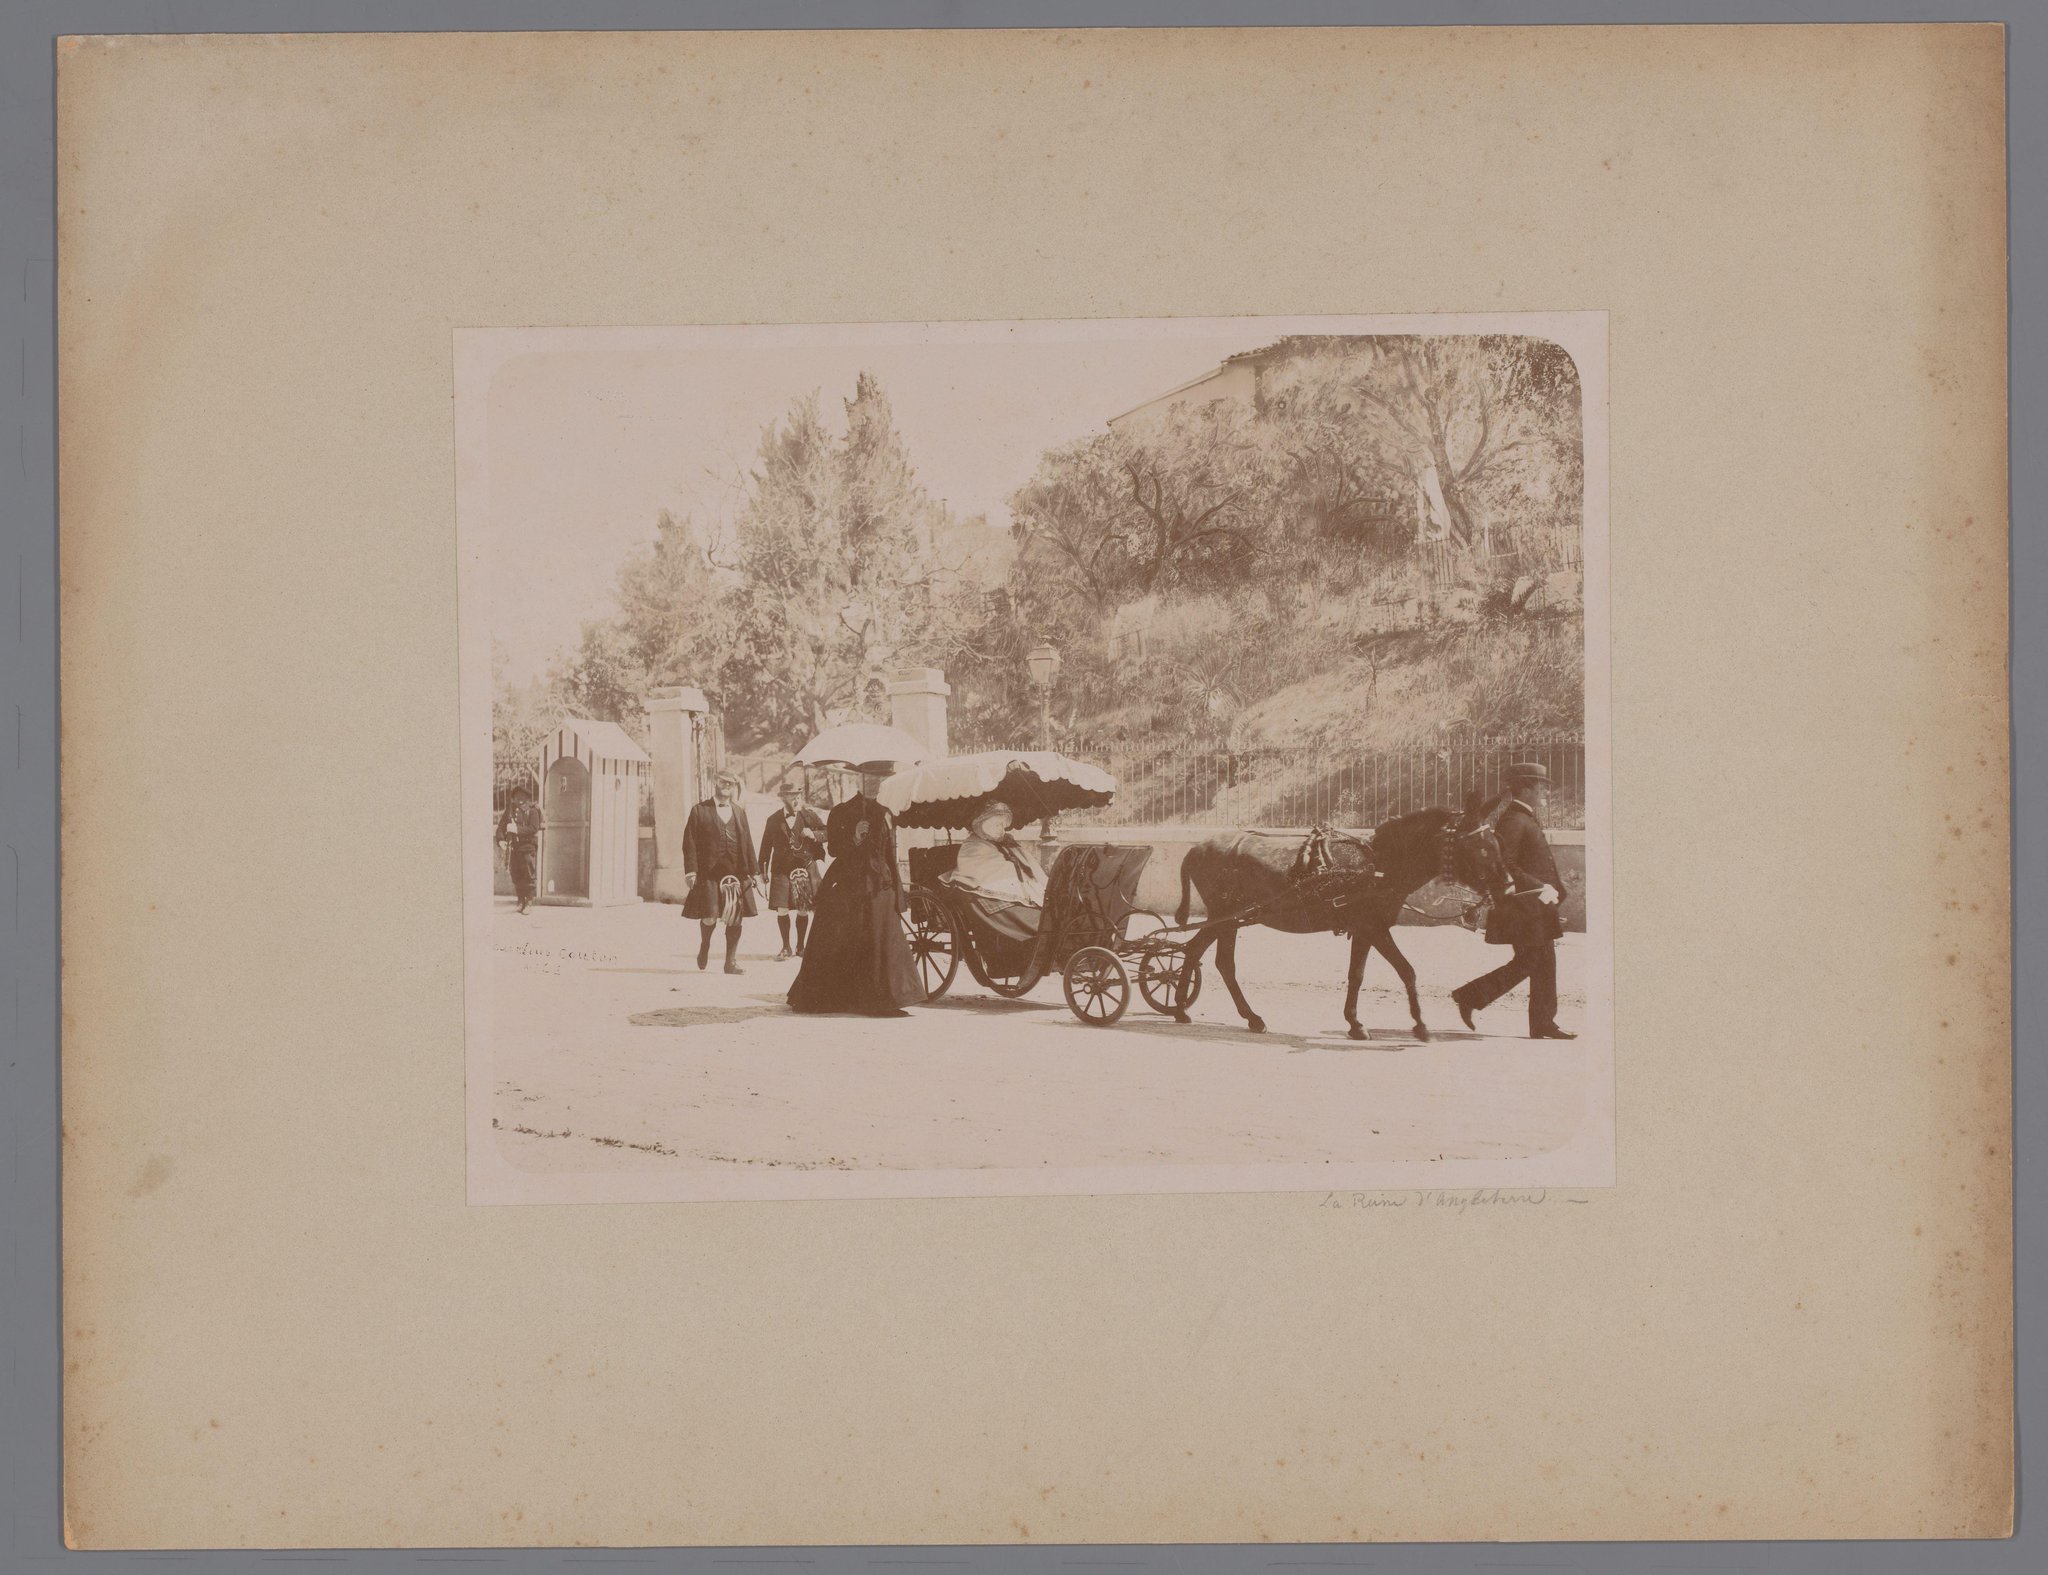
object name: photograph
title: Koningin Victoria in haar rijtuig in een park, Frankrijk [?]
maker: claudius couton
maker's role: fotograaf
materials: cardboard, photographic support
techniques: gelatin silver print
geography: nice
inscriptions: caption, signature: ‘[...] COUTON//NICE’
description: Koningin Victoria in haar rijtuig in een park, met personeel en twee gardes.